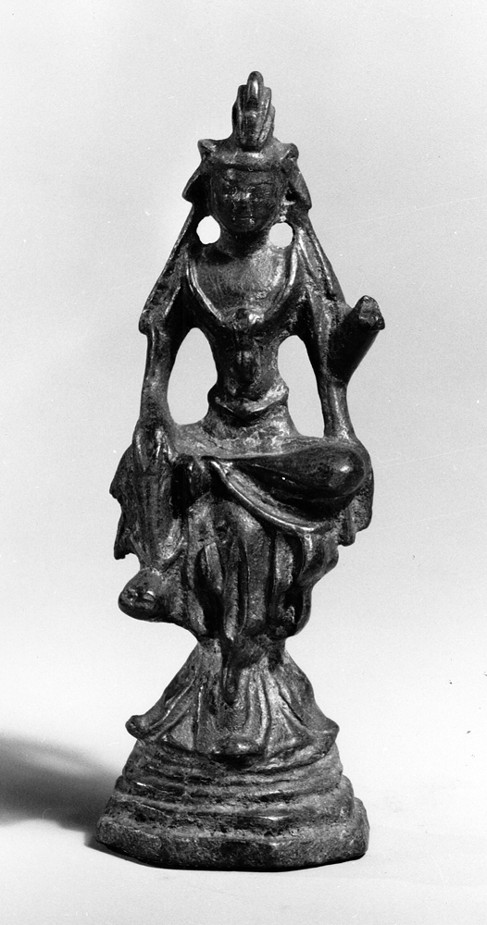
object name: figure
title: Seated bodhisattva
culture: chinese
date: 386-534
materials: bronze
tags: bodhisattvas